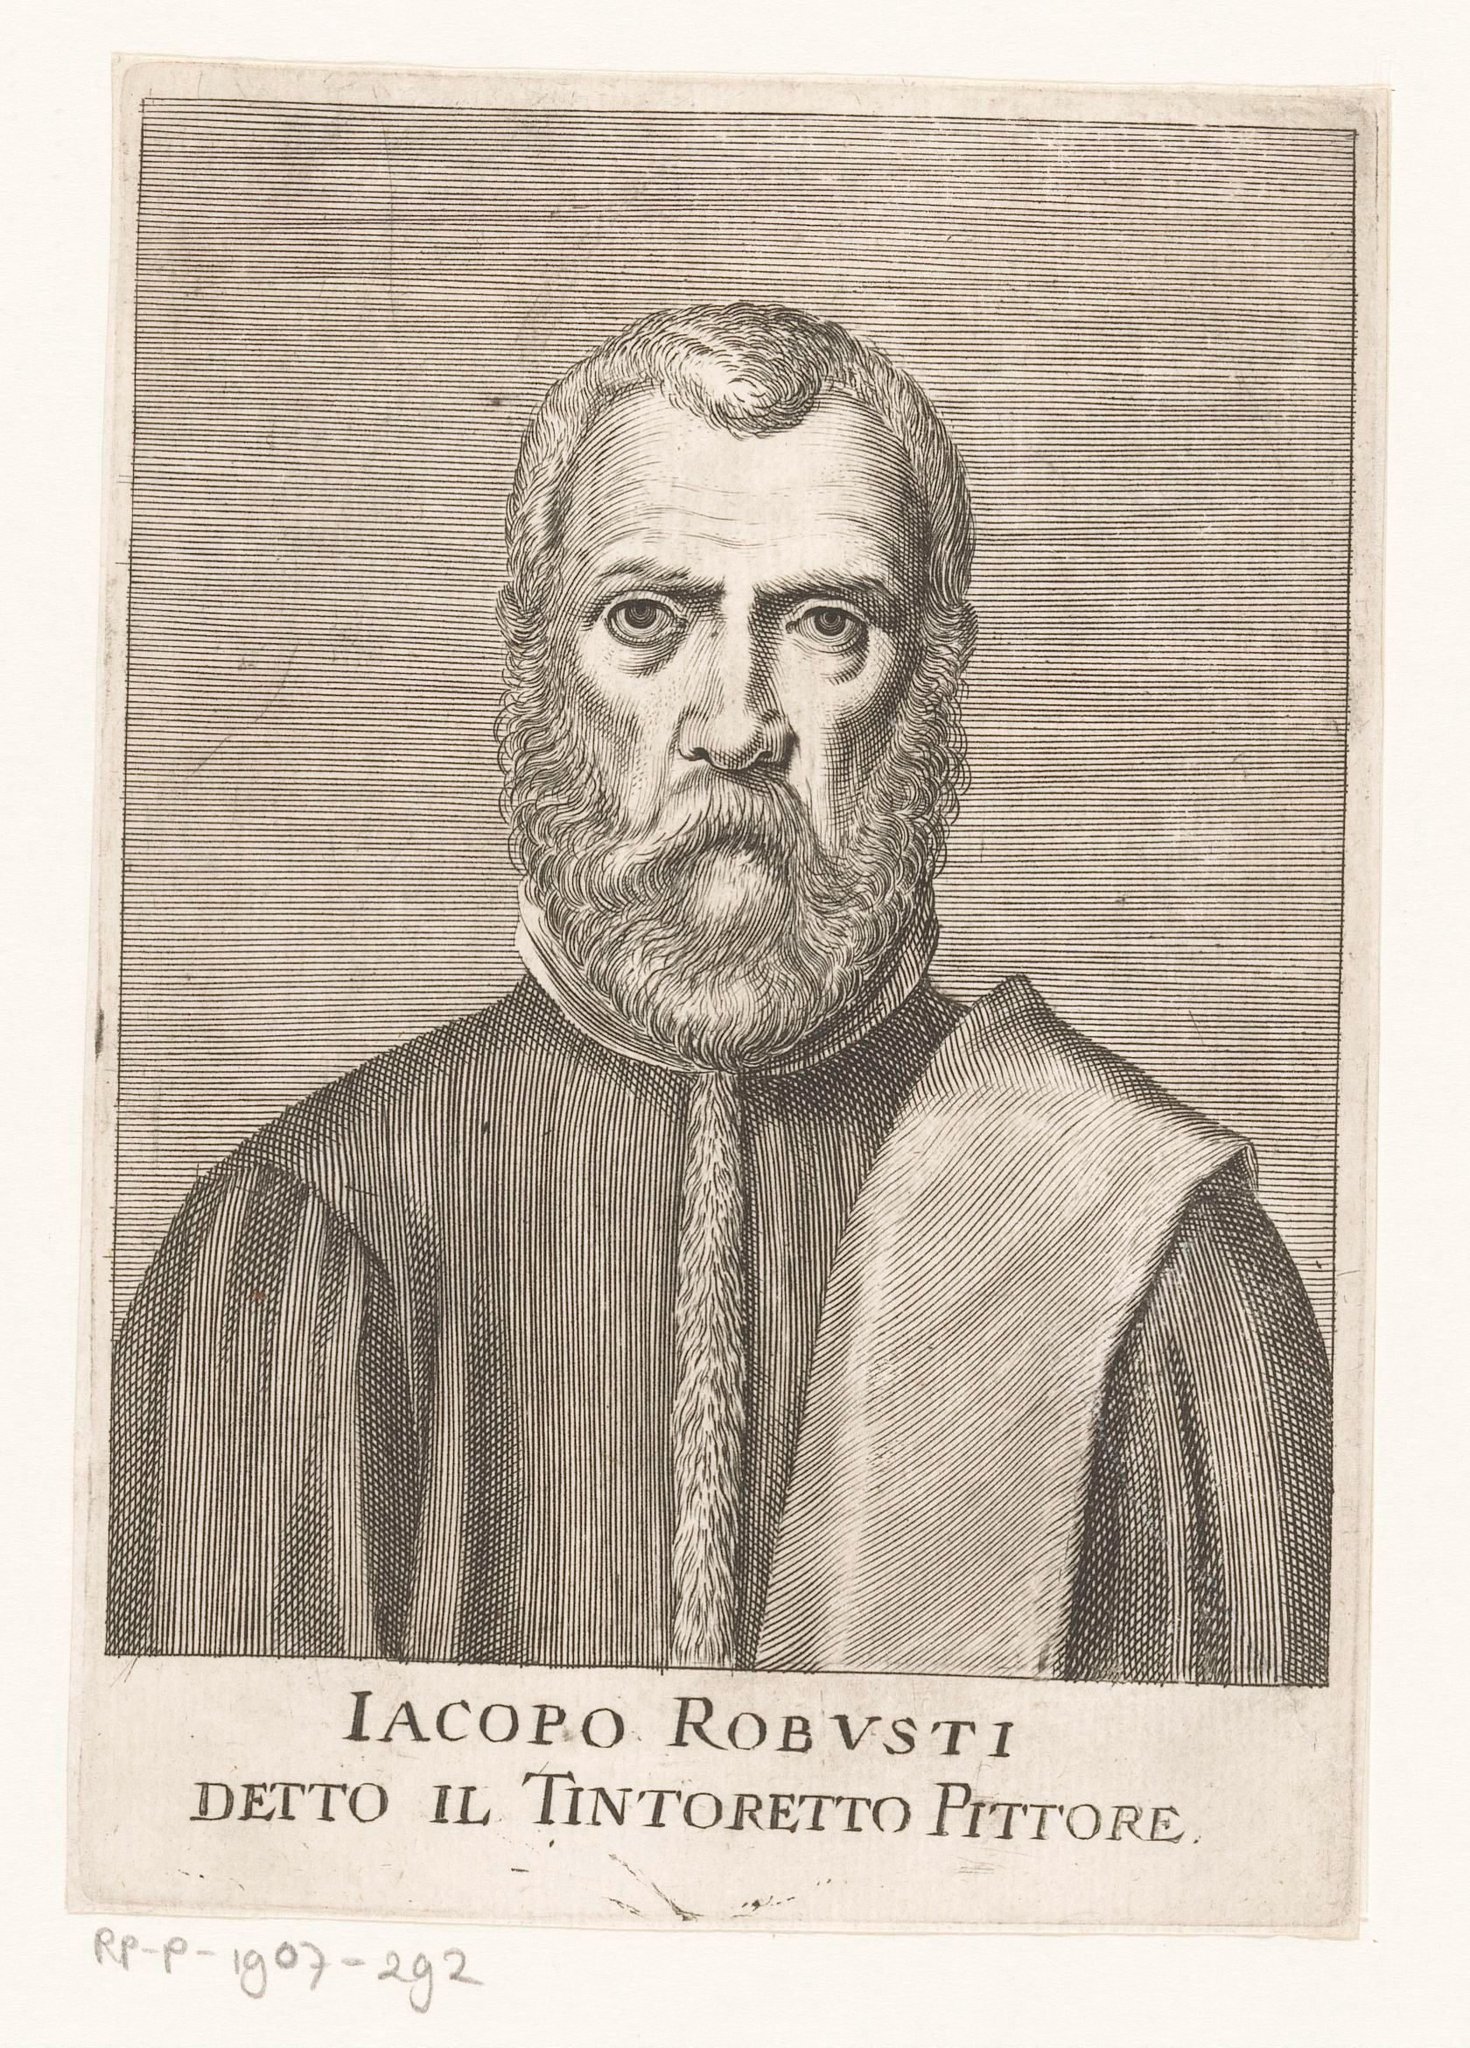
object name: print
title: Portretten van beroemde Italiaanse schilders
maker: monogrammist ip (italië)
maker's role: print maker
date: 1600-1699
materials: paper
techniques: engraving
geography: italy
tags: venice, painter, print maker, draughtsman, jacopo tintoretto, historical persons, portrait, self-portrait of artist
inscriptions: collector's mark: Lugt 2228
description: Deze prent maakt deel uit van een reeks van ten minste negen portretten van beroemde Italiaanse schilders.